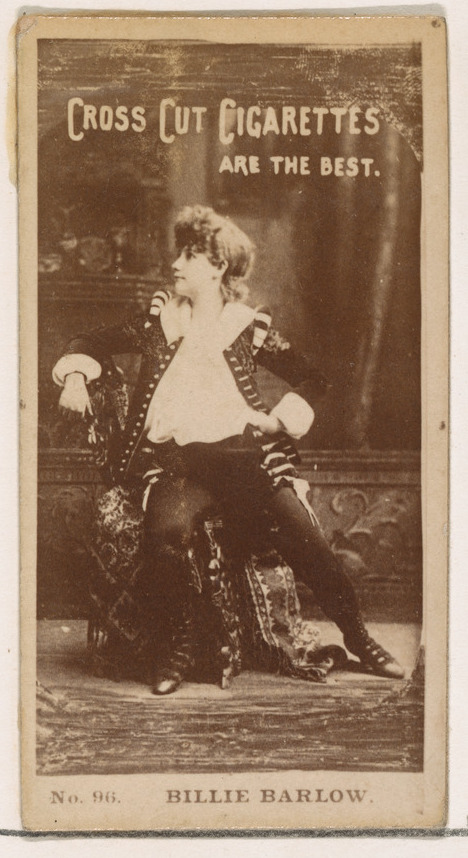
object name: print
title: Card Number 96, Billie Barlow, from the Actors and Actresses series (N145-2) issued by Duke Sons & Co. to promote Cross Cut Cigarettes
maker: w. duke, sons & co.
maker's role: publisher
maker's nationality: american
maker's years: 1870-1920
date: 1880-1889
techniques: albumen silver print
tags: women,actresses